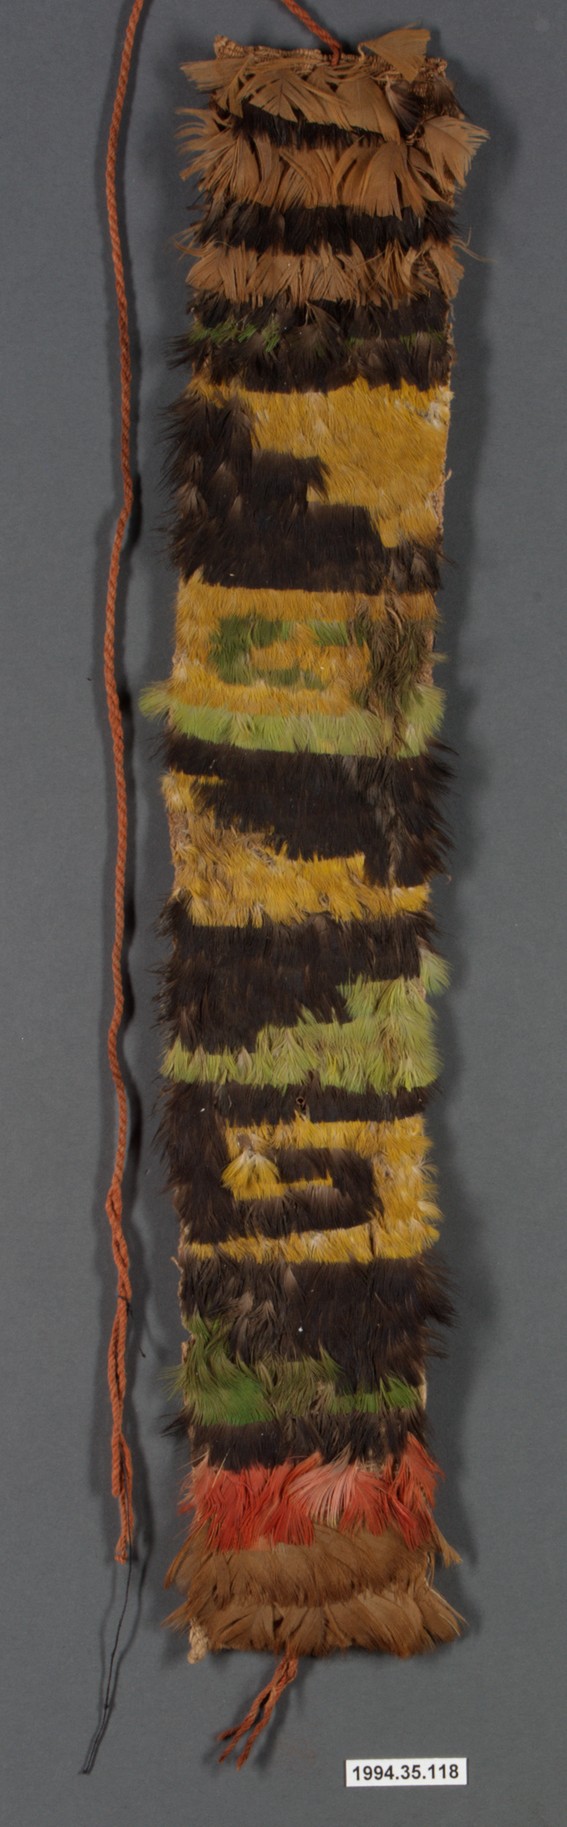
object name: band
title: Feathered Band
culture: peruvian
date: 1301-1533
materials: cotton, feather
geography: peru